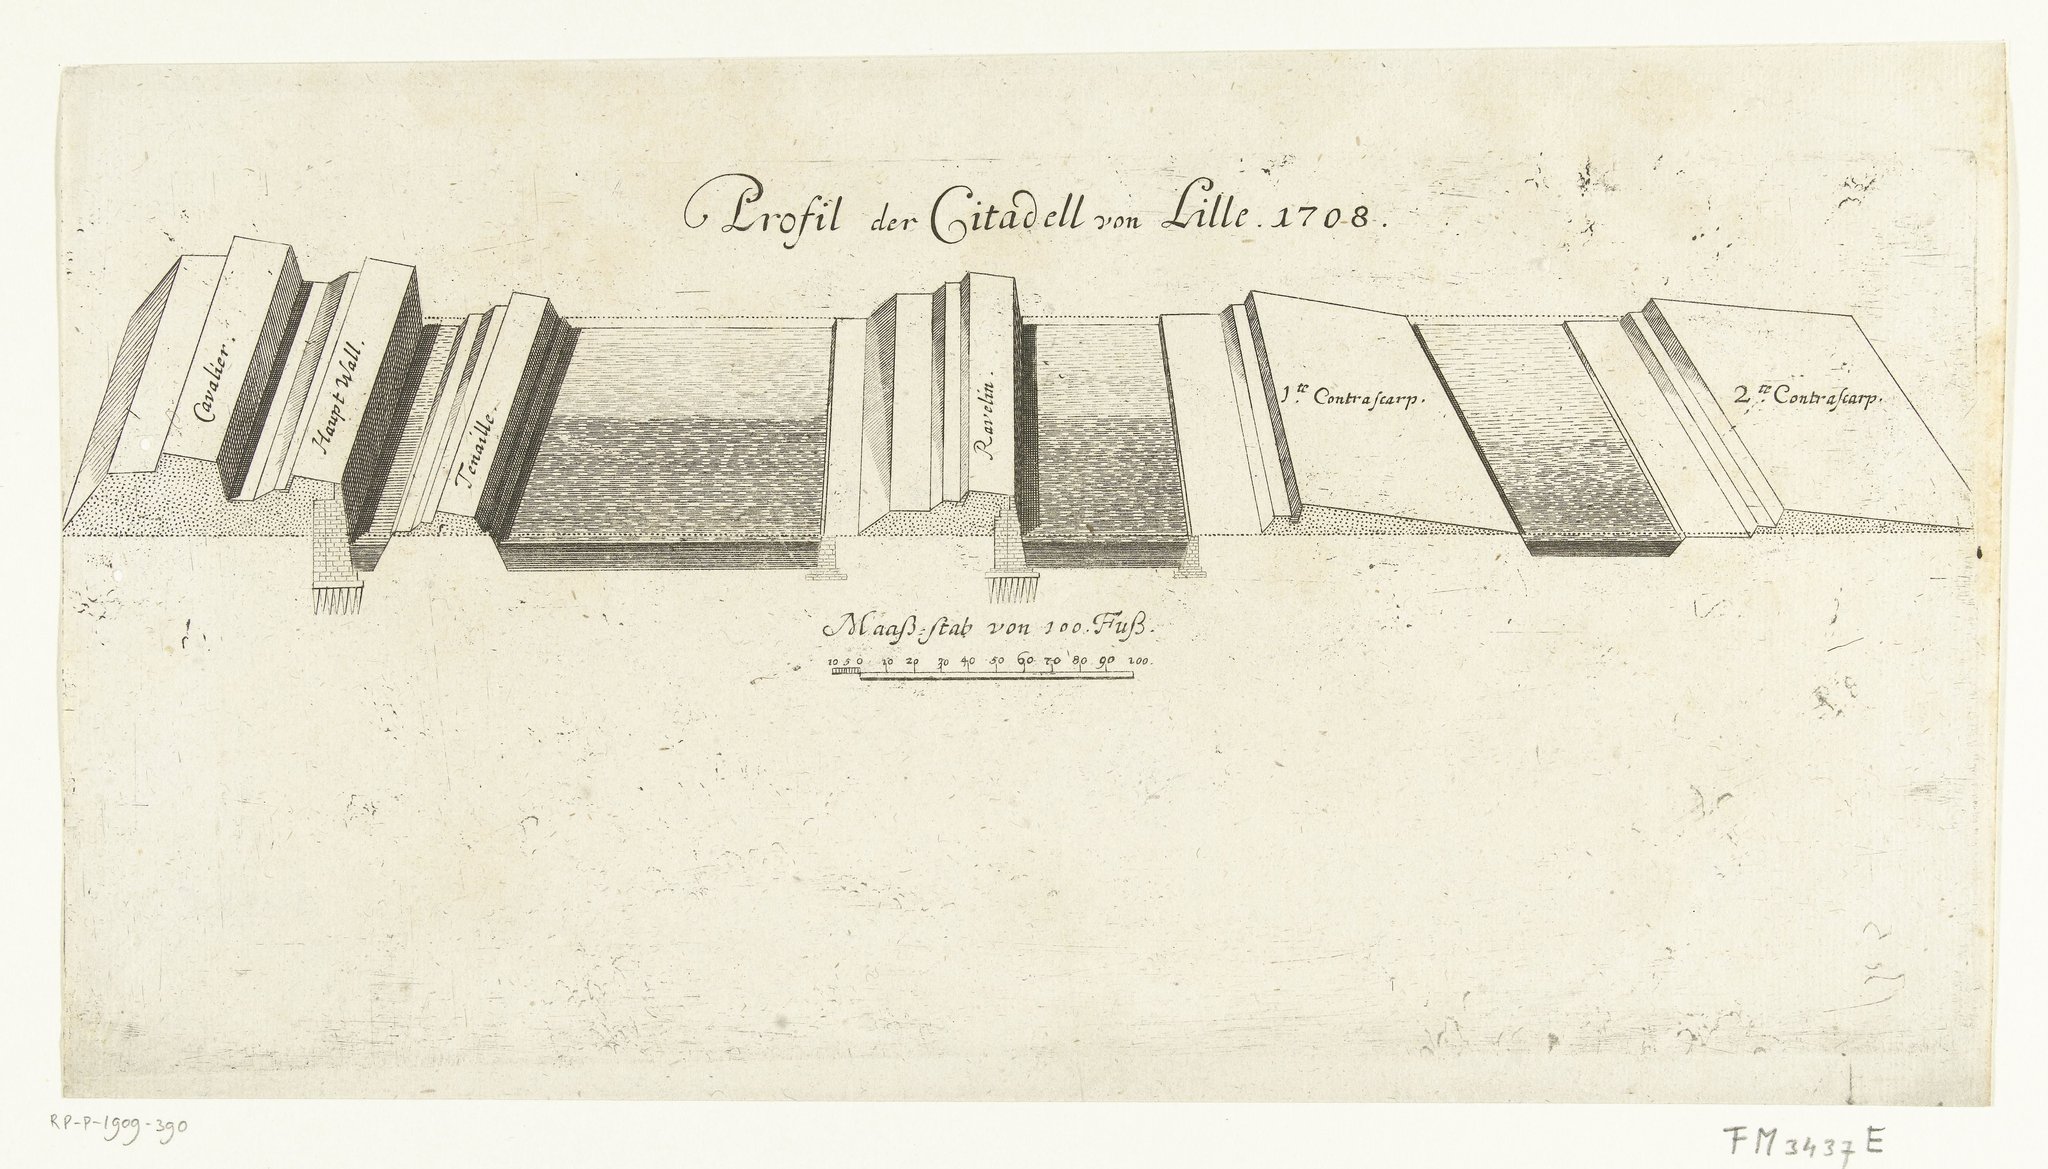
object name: print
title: Profiel van de wallen van de citadel van Lille, 1708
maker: Anonymous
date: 1708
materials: paper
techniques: etching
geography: germany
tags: johan willem friso (prins van oranje-nassau), paris, vienna, eugenius van savoye, fortress, lille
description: Doorsnede van de versterkingen om de citadel of kasteel van Lille (Rijssel), ingenomen door de Geallieerden onder prins Eugenius van Savoye en prins Johan Willem Friso op 8 december 1708.